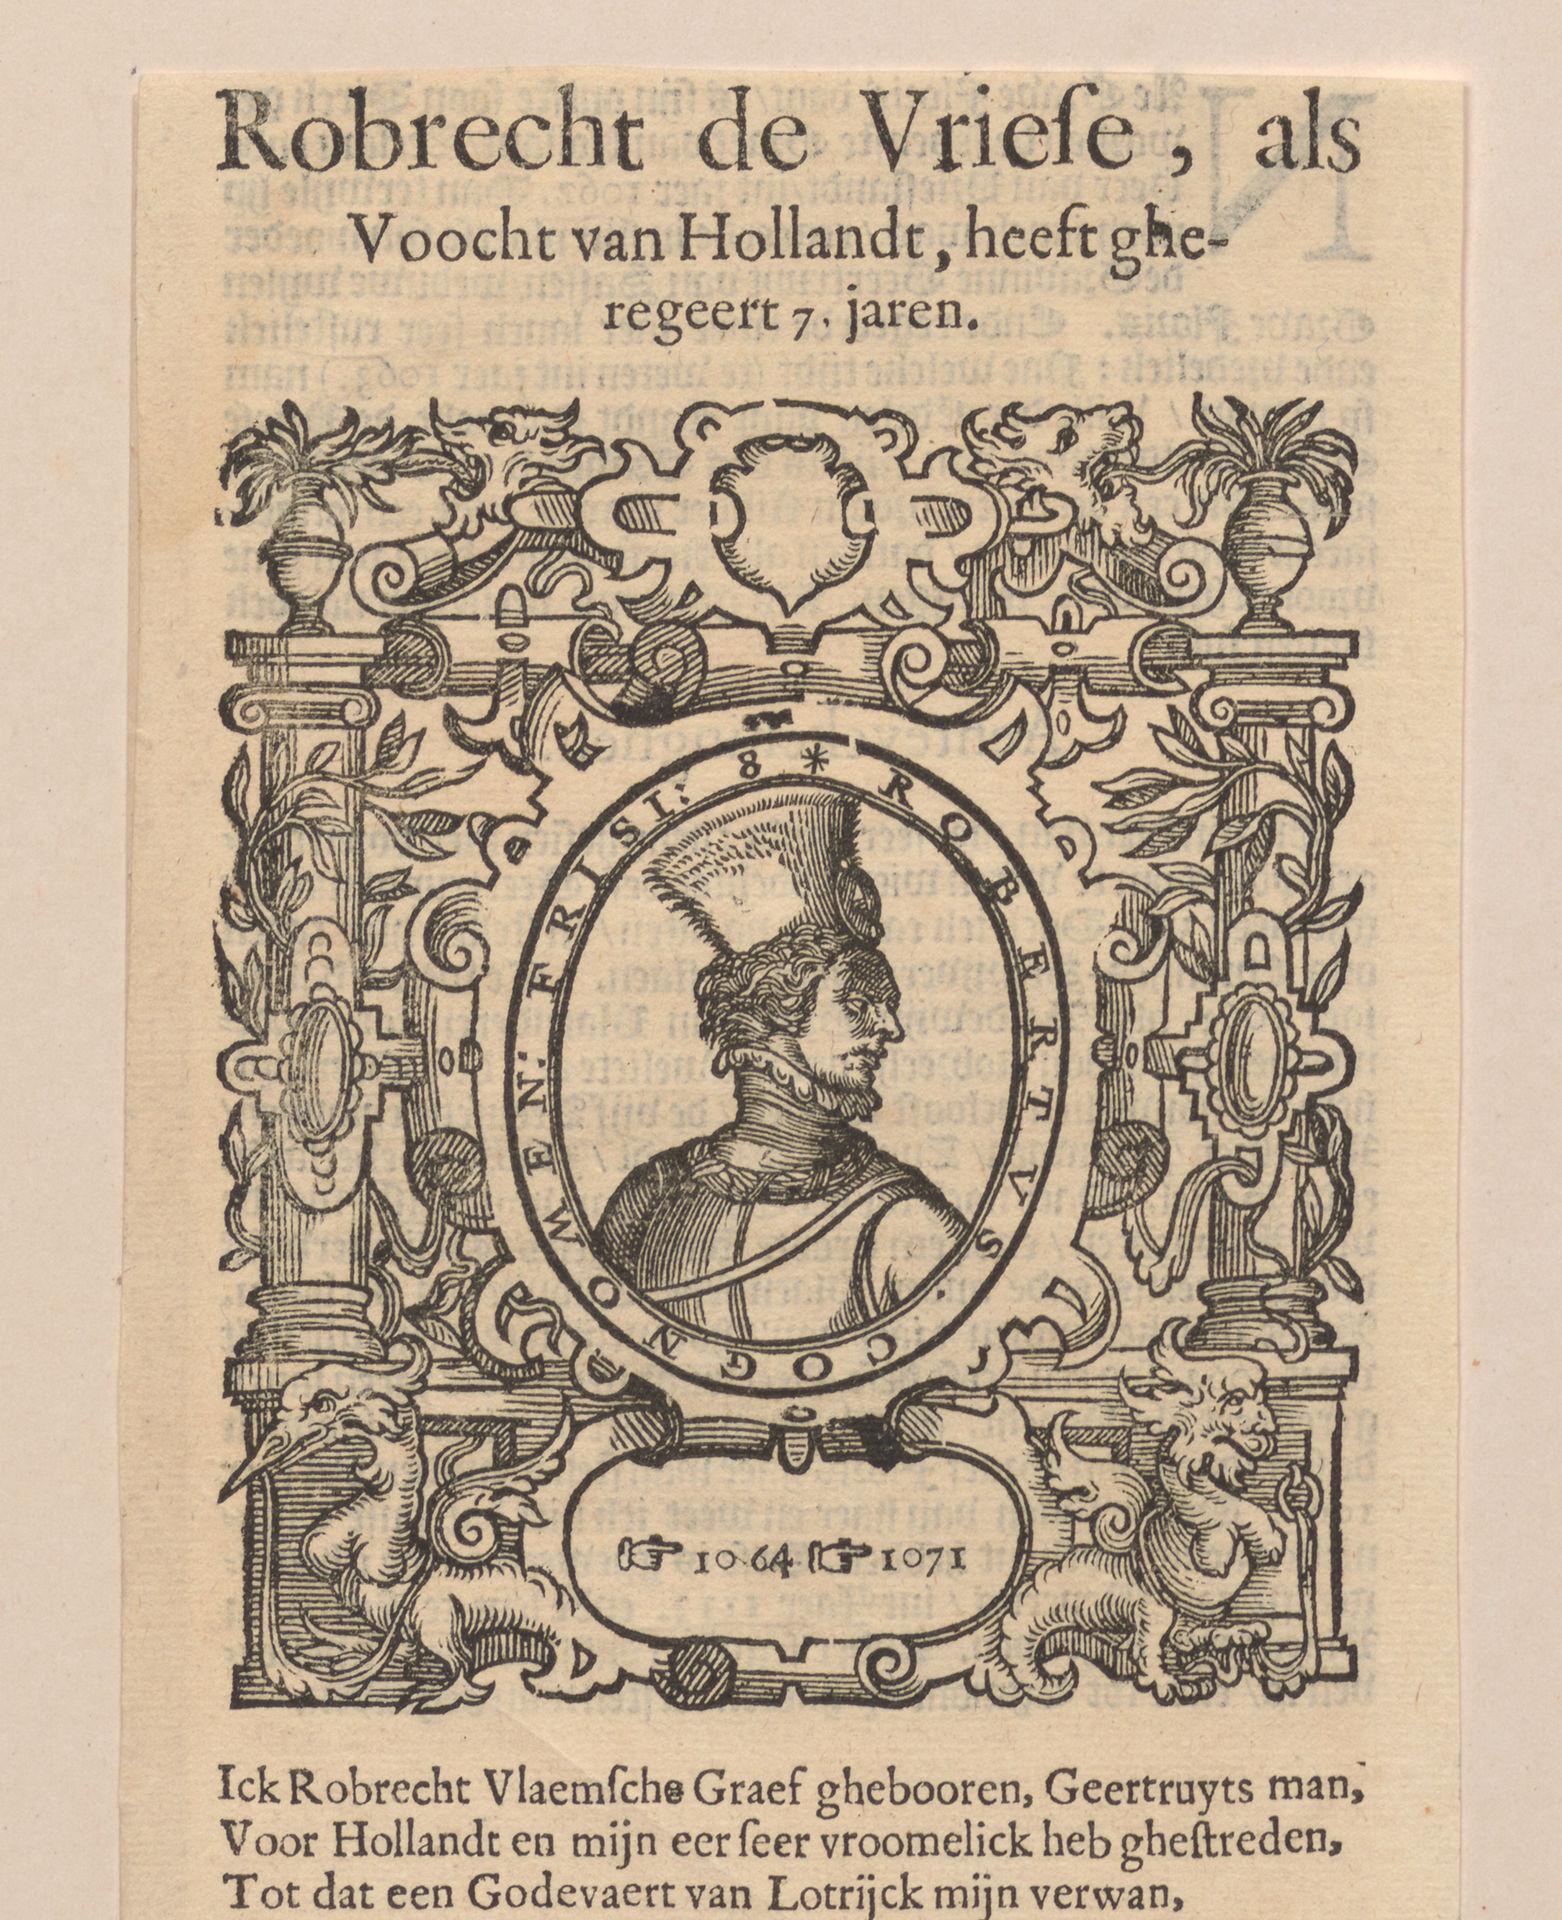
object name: book illustration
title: Portret van Robrecht I de Fries, graaf van Vlaanderen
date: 1636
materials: paper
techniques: letterpress printing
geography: amsterdam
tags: historical persons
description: Prent uit: Scriverius, Petrus. Beschrivinge van out Batavien met de antiquiteyten vandien (...). Amsterdam: Jan Evertsz Cloppenburgh II, 1636. Prent met andere tekst gebruikt in eerdere publicatie (1606).